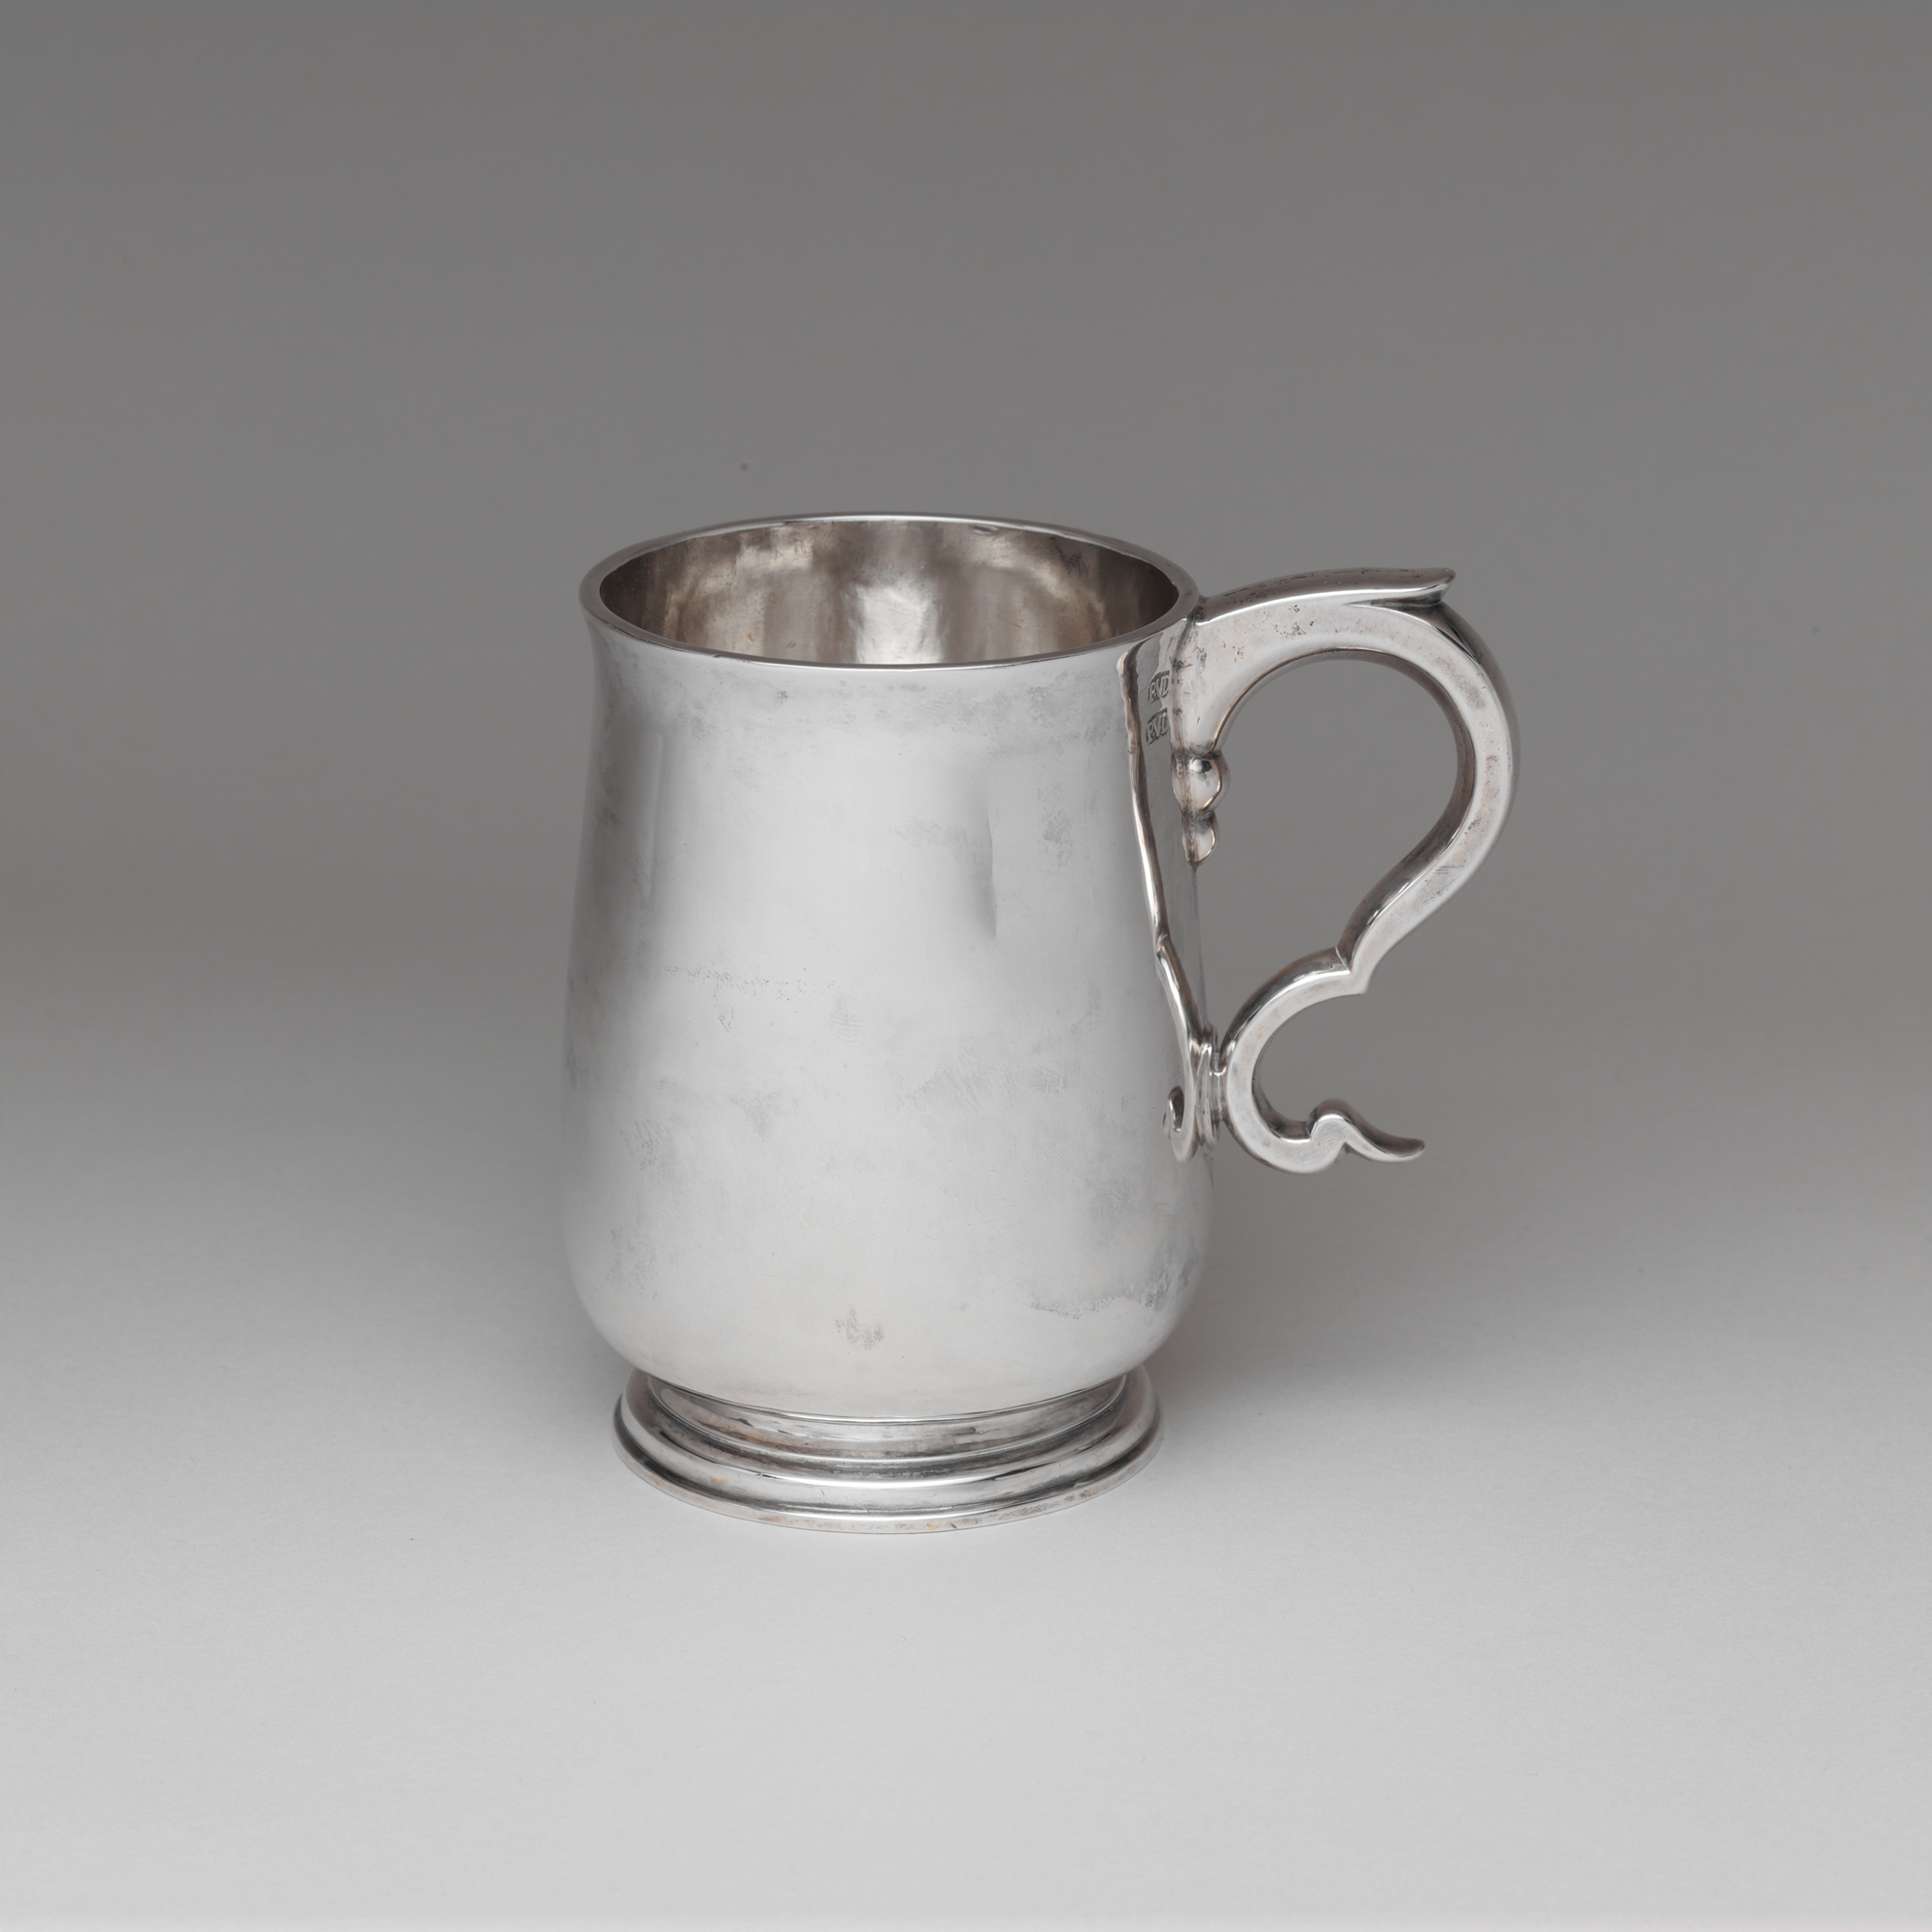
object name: cann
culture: american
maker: peter van dyck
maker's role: maker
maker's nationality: american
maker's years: 1684-1750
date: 1735-1750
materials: silver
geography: united states